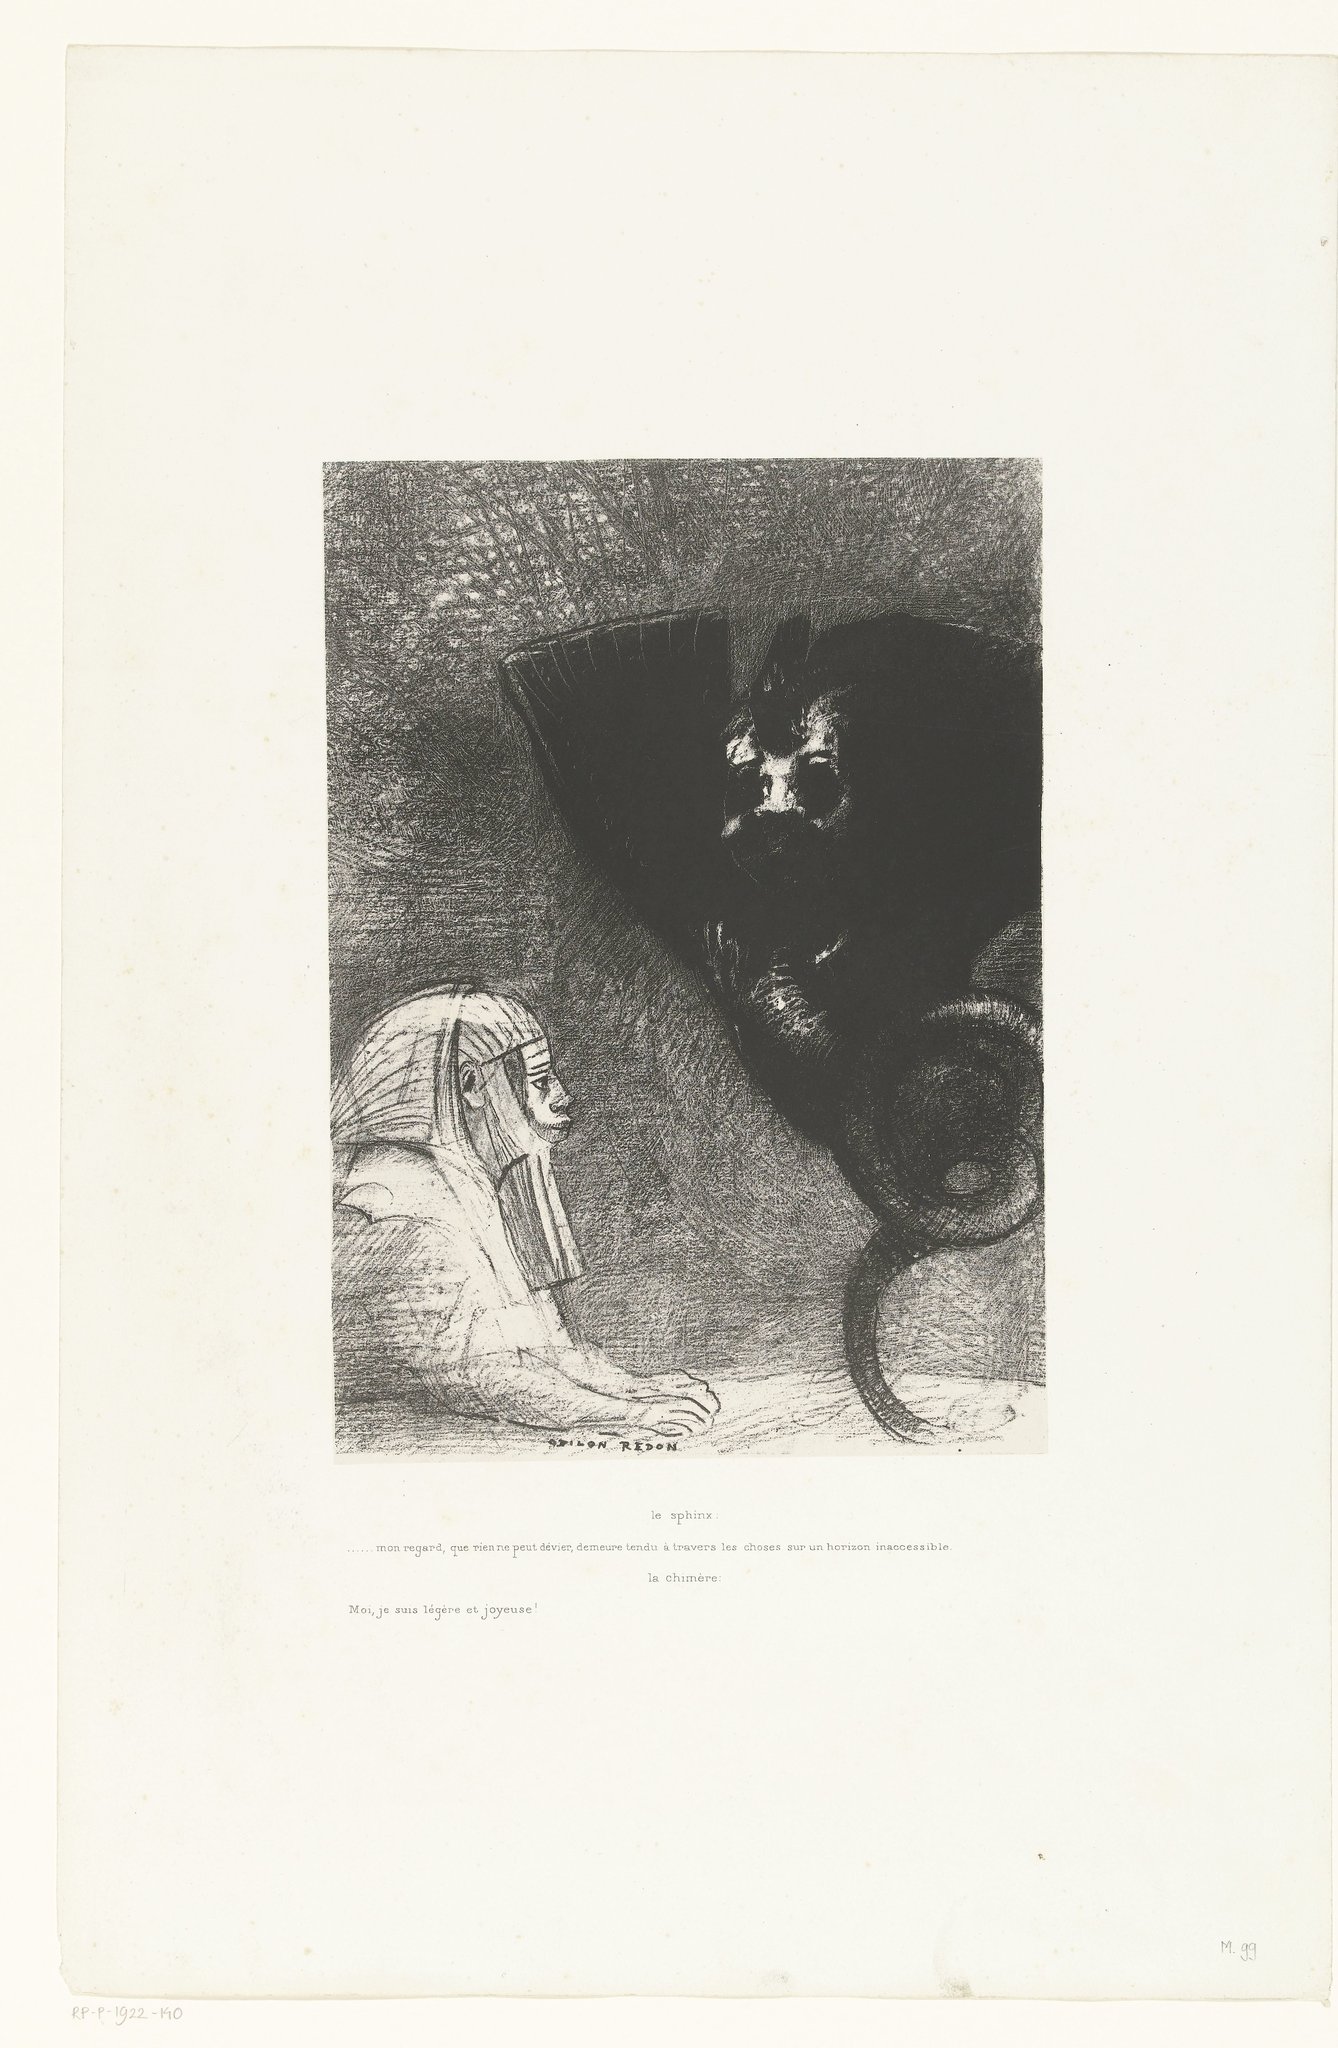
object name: print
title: Tentation de Saint-Antoine (2)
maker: odilon redon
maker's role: draughtsman, painter, print maker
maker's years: 1840-1916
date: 1889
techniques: printmaking, lithograph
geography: france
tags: sphinx (lion/woman); 'sfinge' (ripa), temptations of st. antony abbot, chimera (lion/goat/snake); 'chimera' (ripa)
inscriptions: collector's mark: Lugt 2228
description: Links een sfinx, rechts een chimaera, een monster met vleugels en een slangenstaart. Onder de afbeelding de tekst: De Sfinx: mijn onafwendbare blik blijft gericht op alle dingen op een onbereikbare horizon, de Chimaera: Ik, ik ben vol van licht en vreugde! Vijfde prent van zes uit de tweede serie illustraties voor Gustave Flauberts De verzoeking van de heilige Antonius.